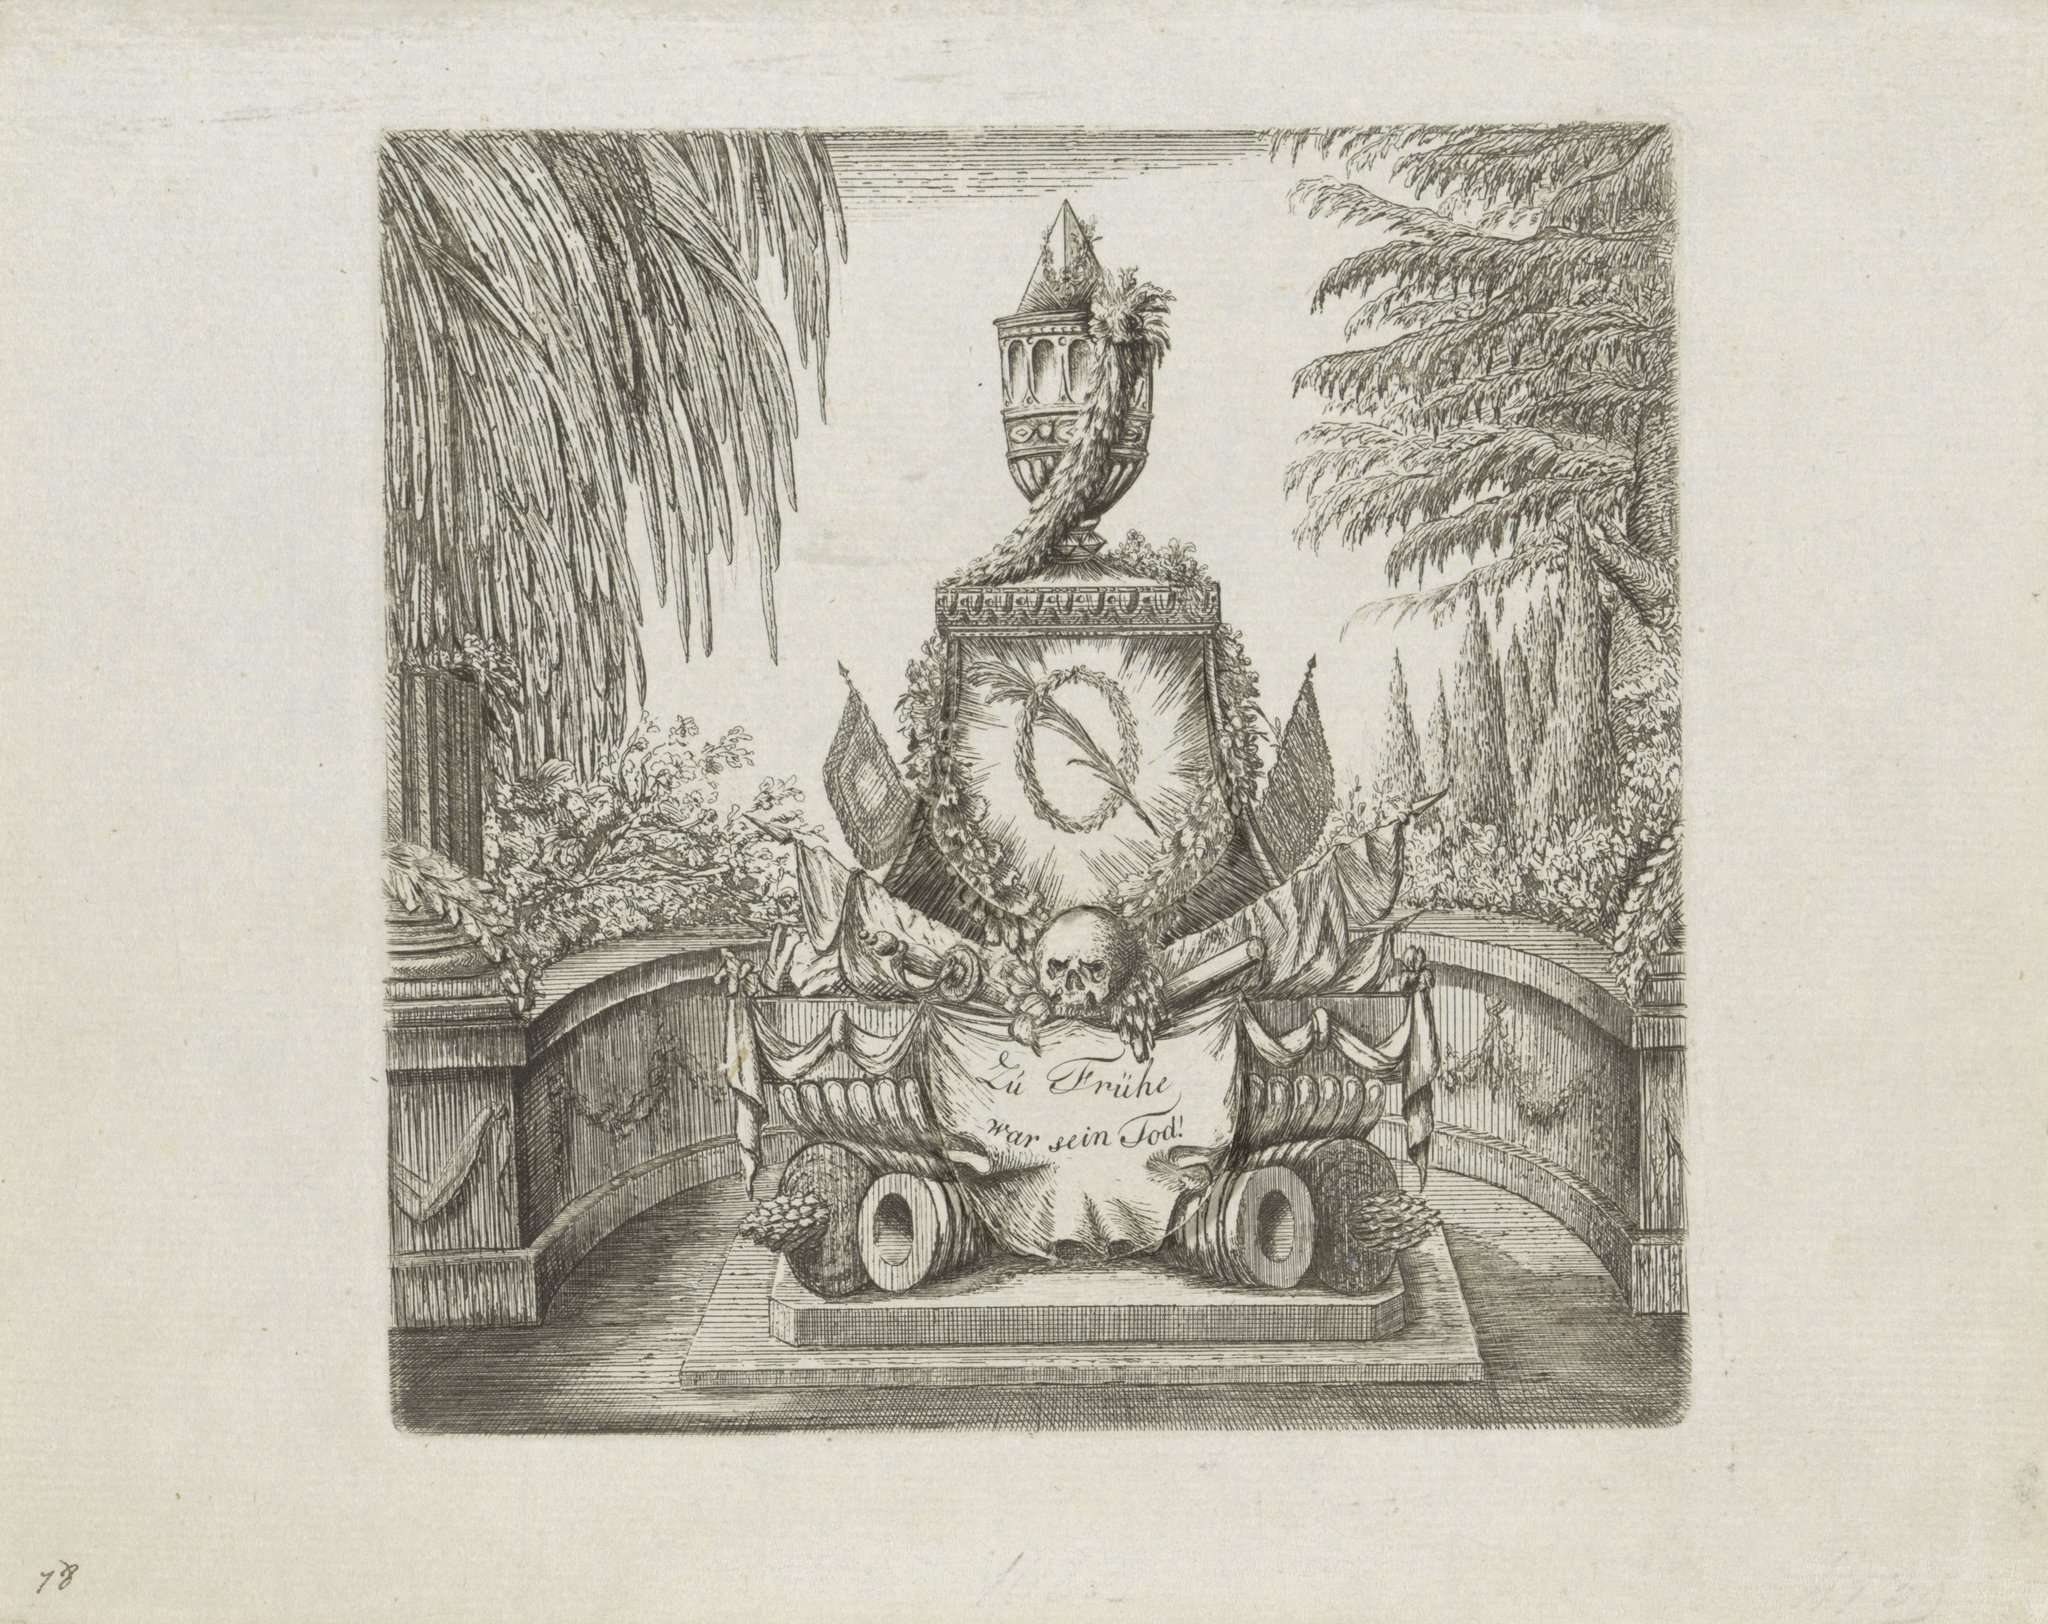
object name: print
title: Zu Frühe war sein Tod!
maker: Anonymous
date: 1799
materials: paper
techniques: engraving, etching, letterpress printing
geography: germany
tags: the hague, willem george frederik (prins van oranje-nassau), grave-building, monumental tomb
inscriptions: collector's mark: Lugt 2228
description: Allegorisch grafmonument voor Willem George Frederik, prins van Oranje-Nassau, overleden te Padua, 6 januari 1799. Monument met urn en wapentrofee, in een hof met bomen. Met twee flappen die opgetild kunnen worden waardoor de onderliggende in goud gedrukte opschriften over de overleden prins zichtbaar worden.